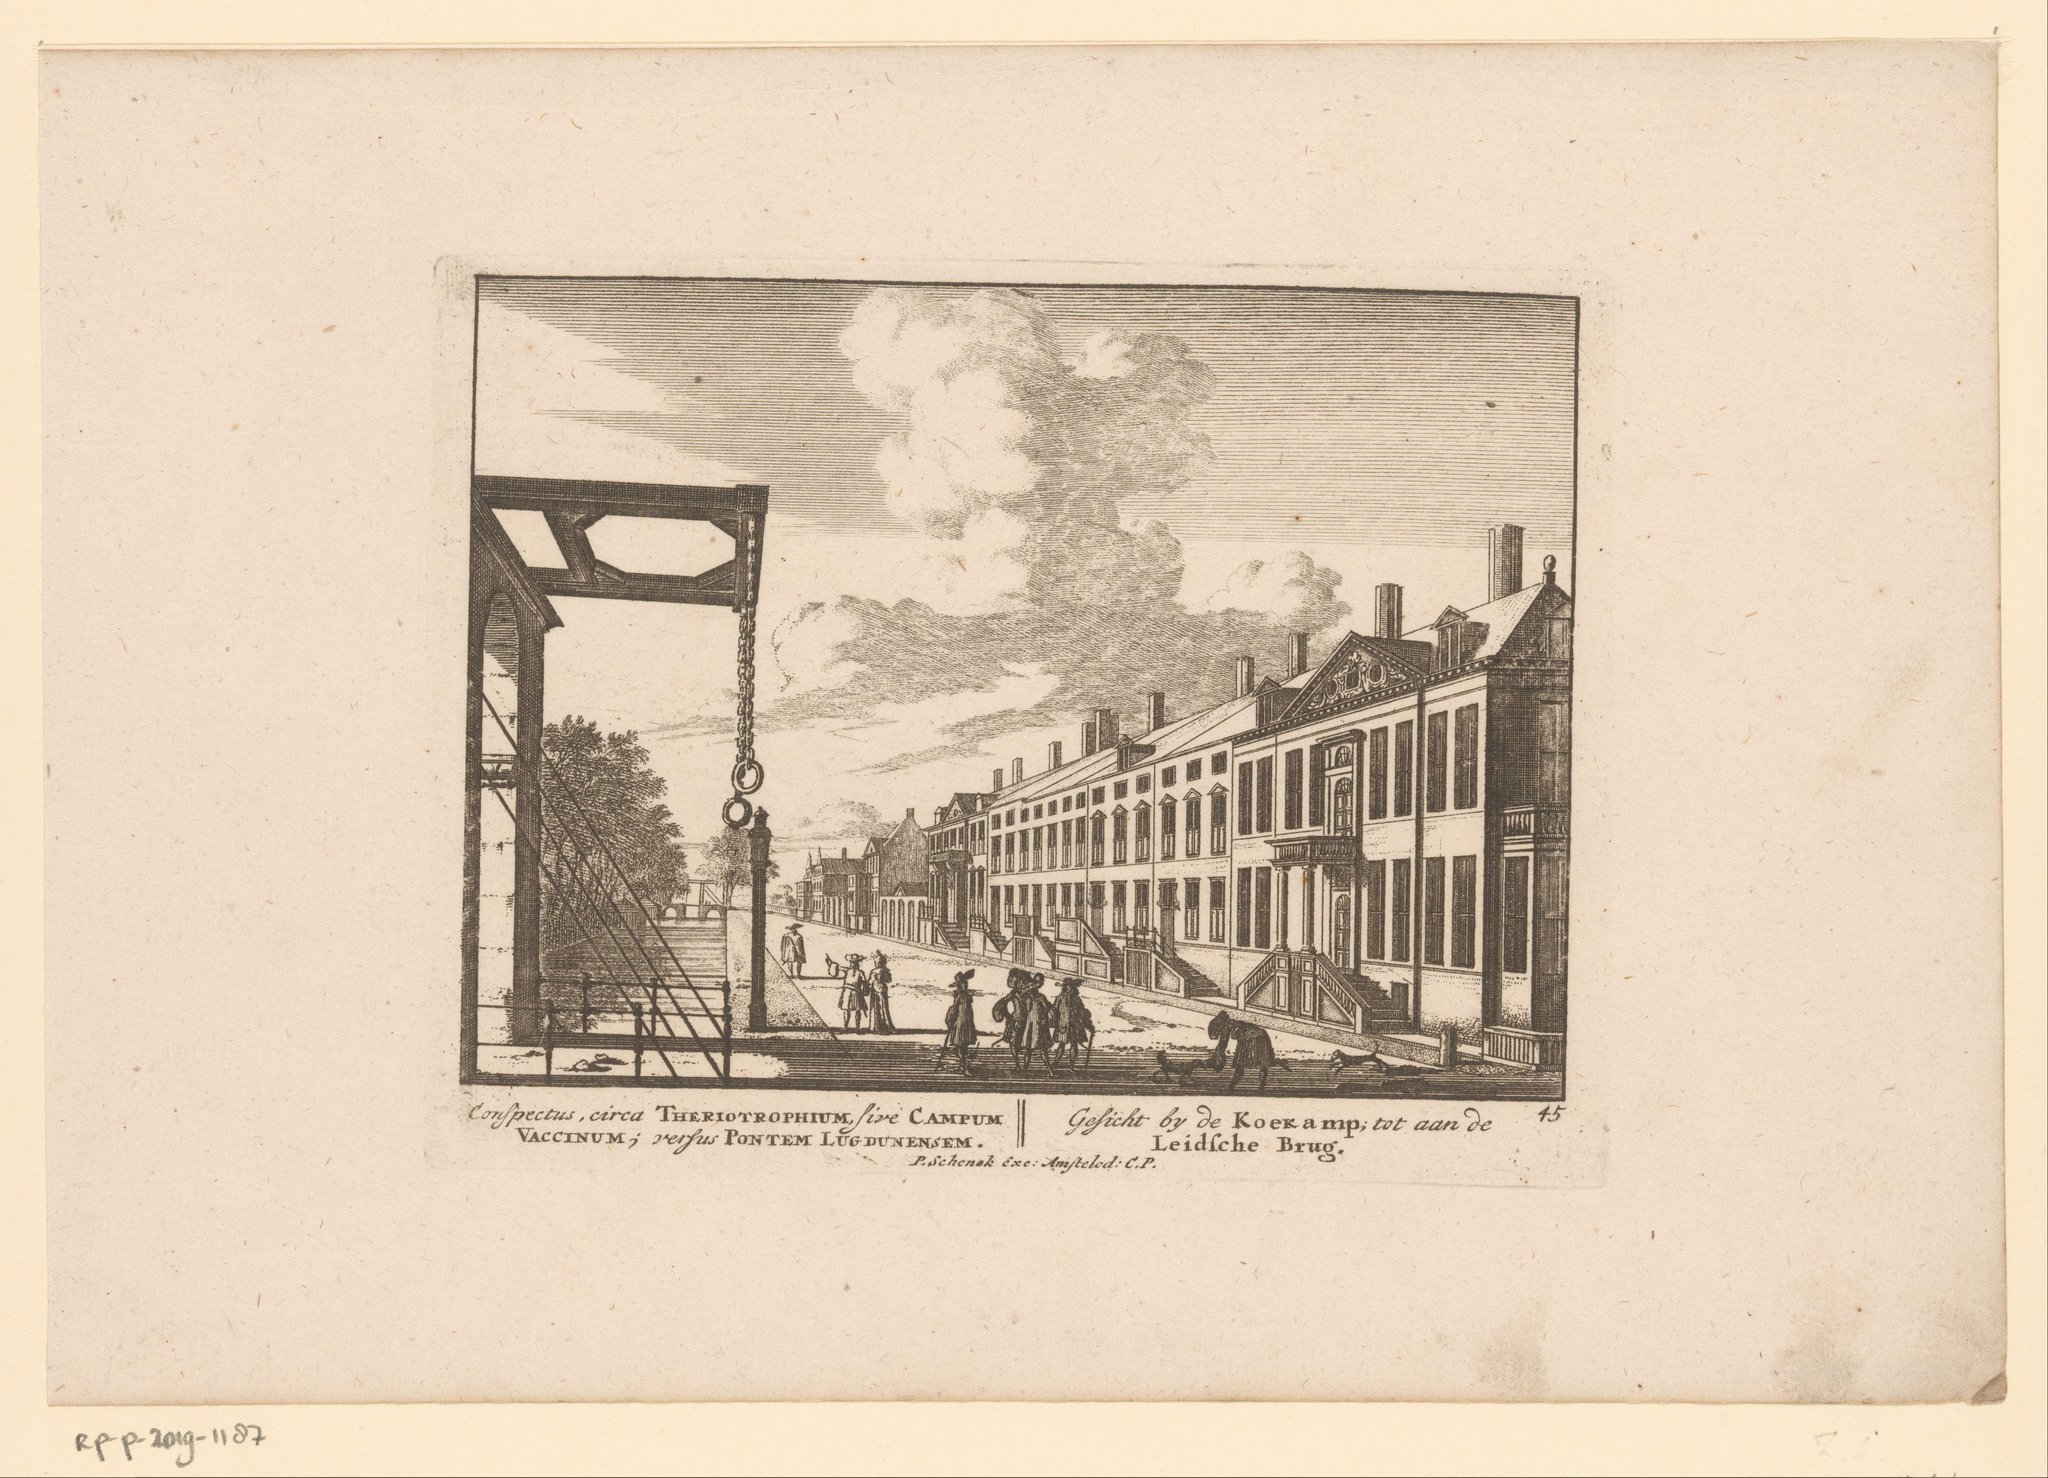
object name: print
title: Admirandorum Quadruplex Spectaculum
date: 1700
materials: paper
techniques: etching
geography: amsterdam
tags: city-view, and landscape with man-made constructions, canals, waters (in city), bridge, the hague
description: Andere staat ook gebruikt in: Call, Jan van. Admirandorum Quadruplex Spectaculum. Amsterdam: Pieter Schenk (I), 1700. De titelprent, opdracht en het portret van Frederik van Saksen zijn gegraveerd door Pieter Schenk (I). De overige prenten uit deze serie zijn, zoals aangegeven op de titelprent, van de hand van Jan van Call (I).